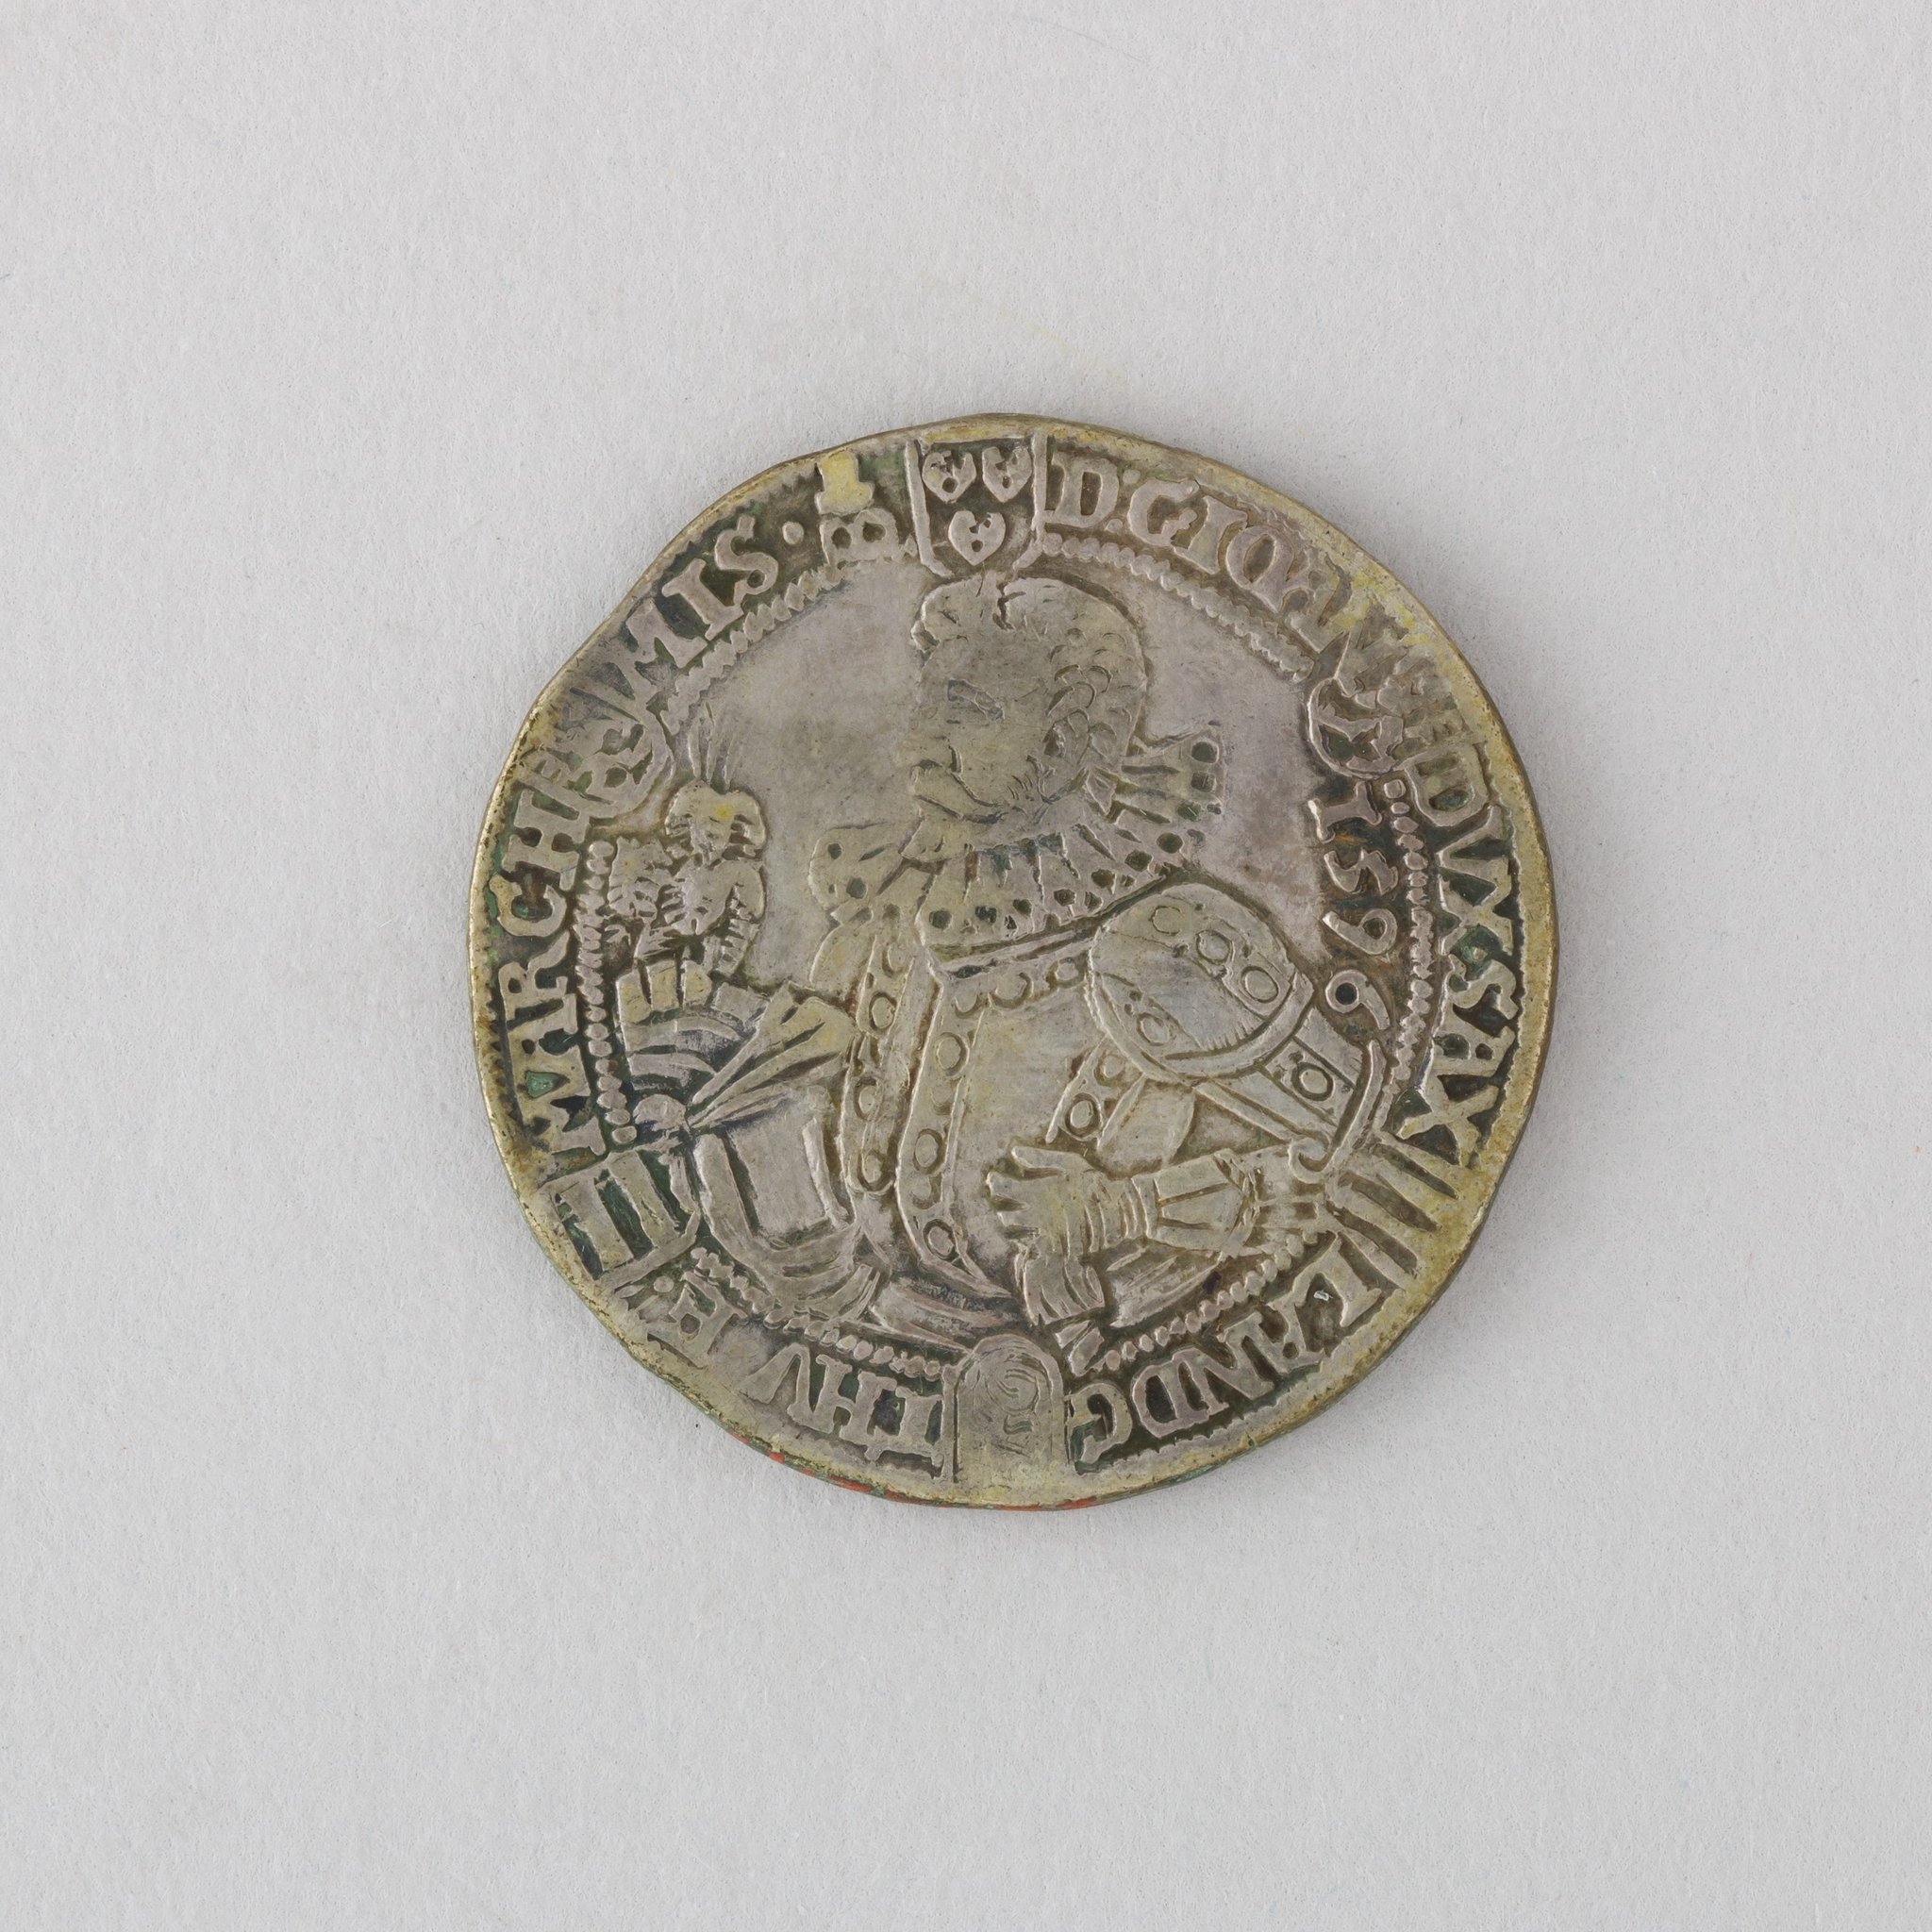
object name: coin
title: Coin Showing Friedrich Wilhelm, Elector of Saxony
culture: german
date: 1596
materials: silver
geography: germany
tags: men,profiles